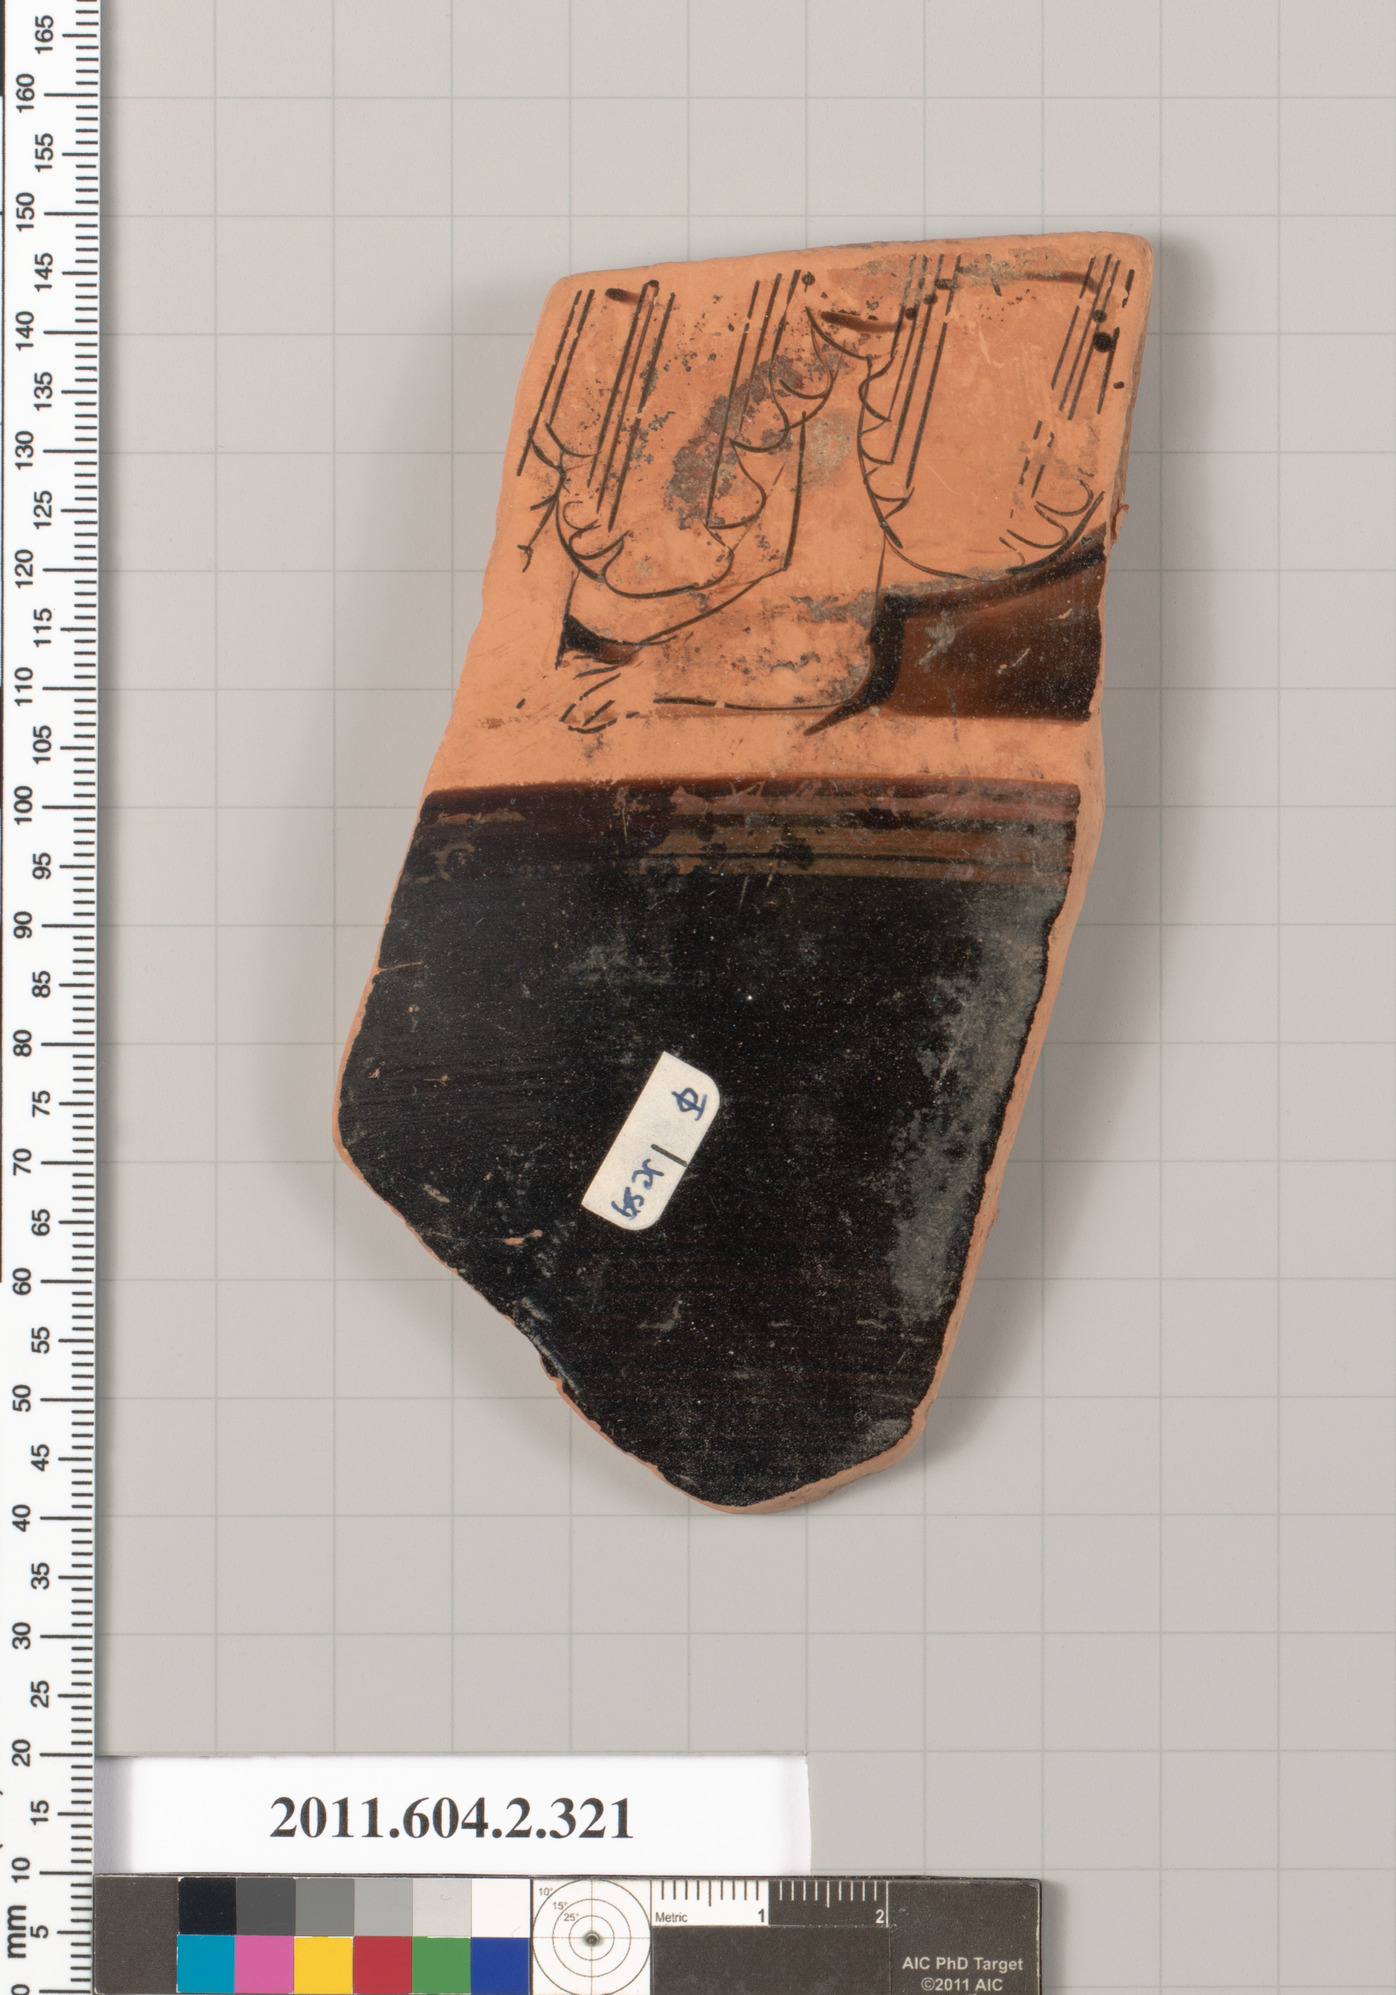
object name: column krater fragment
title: Terracotta fragment of a column-krater (bowl for mixing wine and water)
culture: greek, attic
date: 475-451 BCE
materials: terracotta